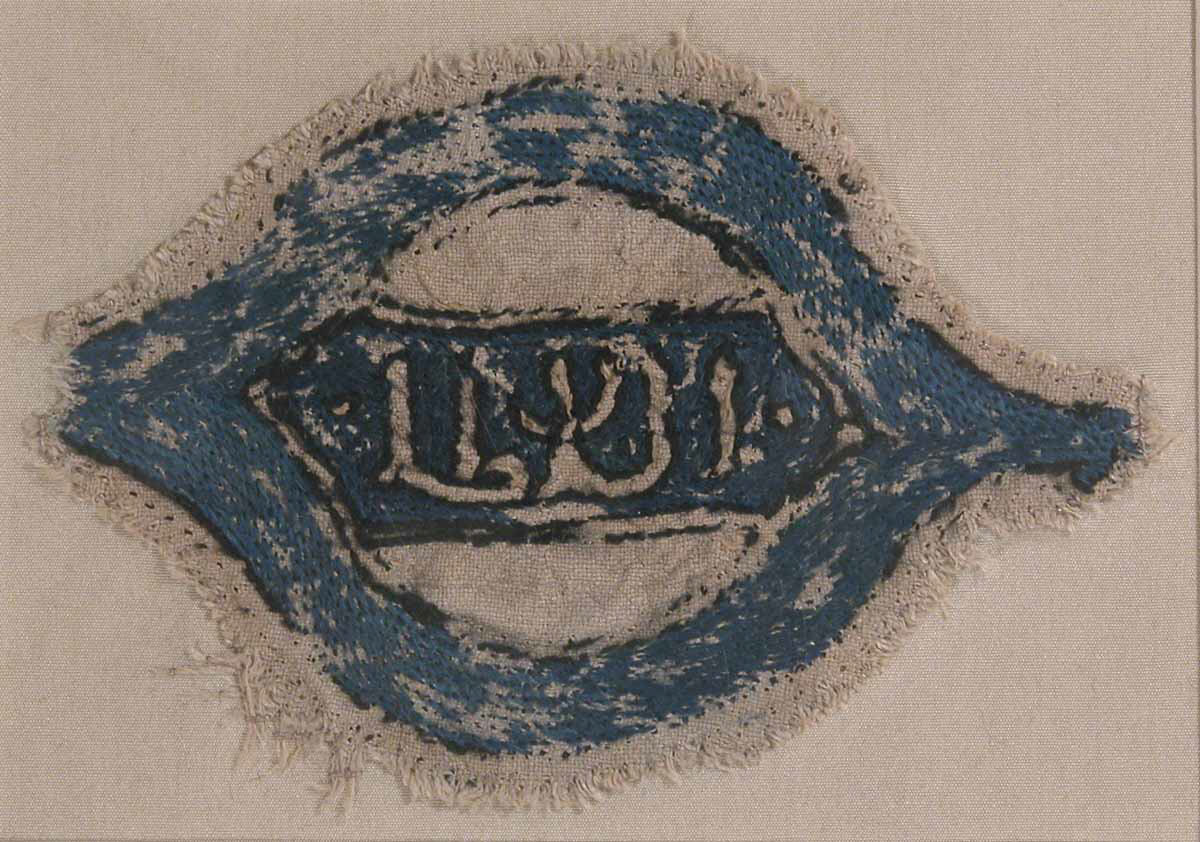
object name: blazon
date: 1301-1400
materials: linen, silk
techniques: embroidery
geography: egypt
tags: insignia